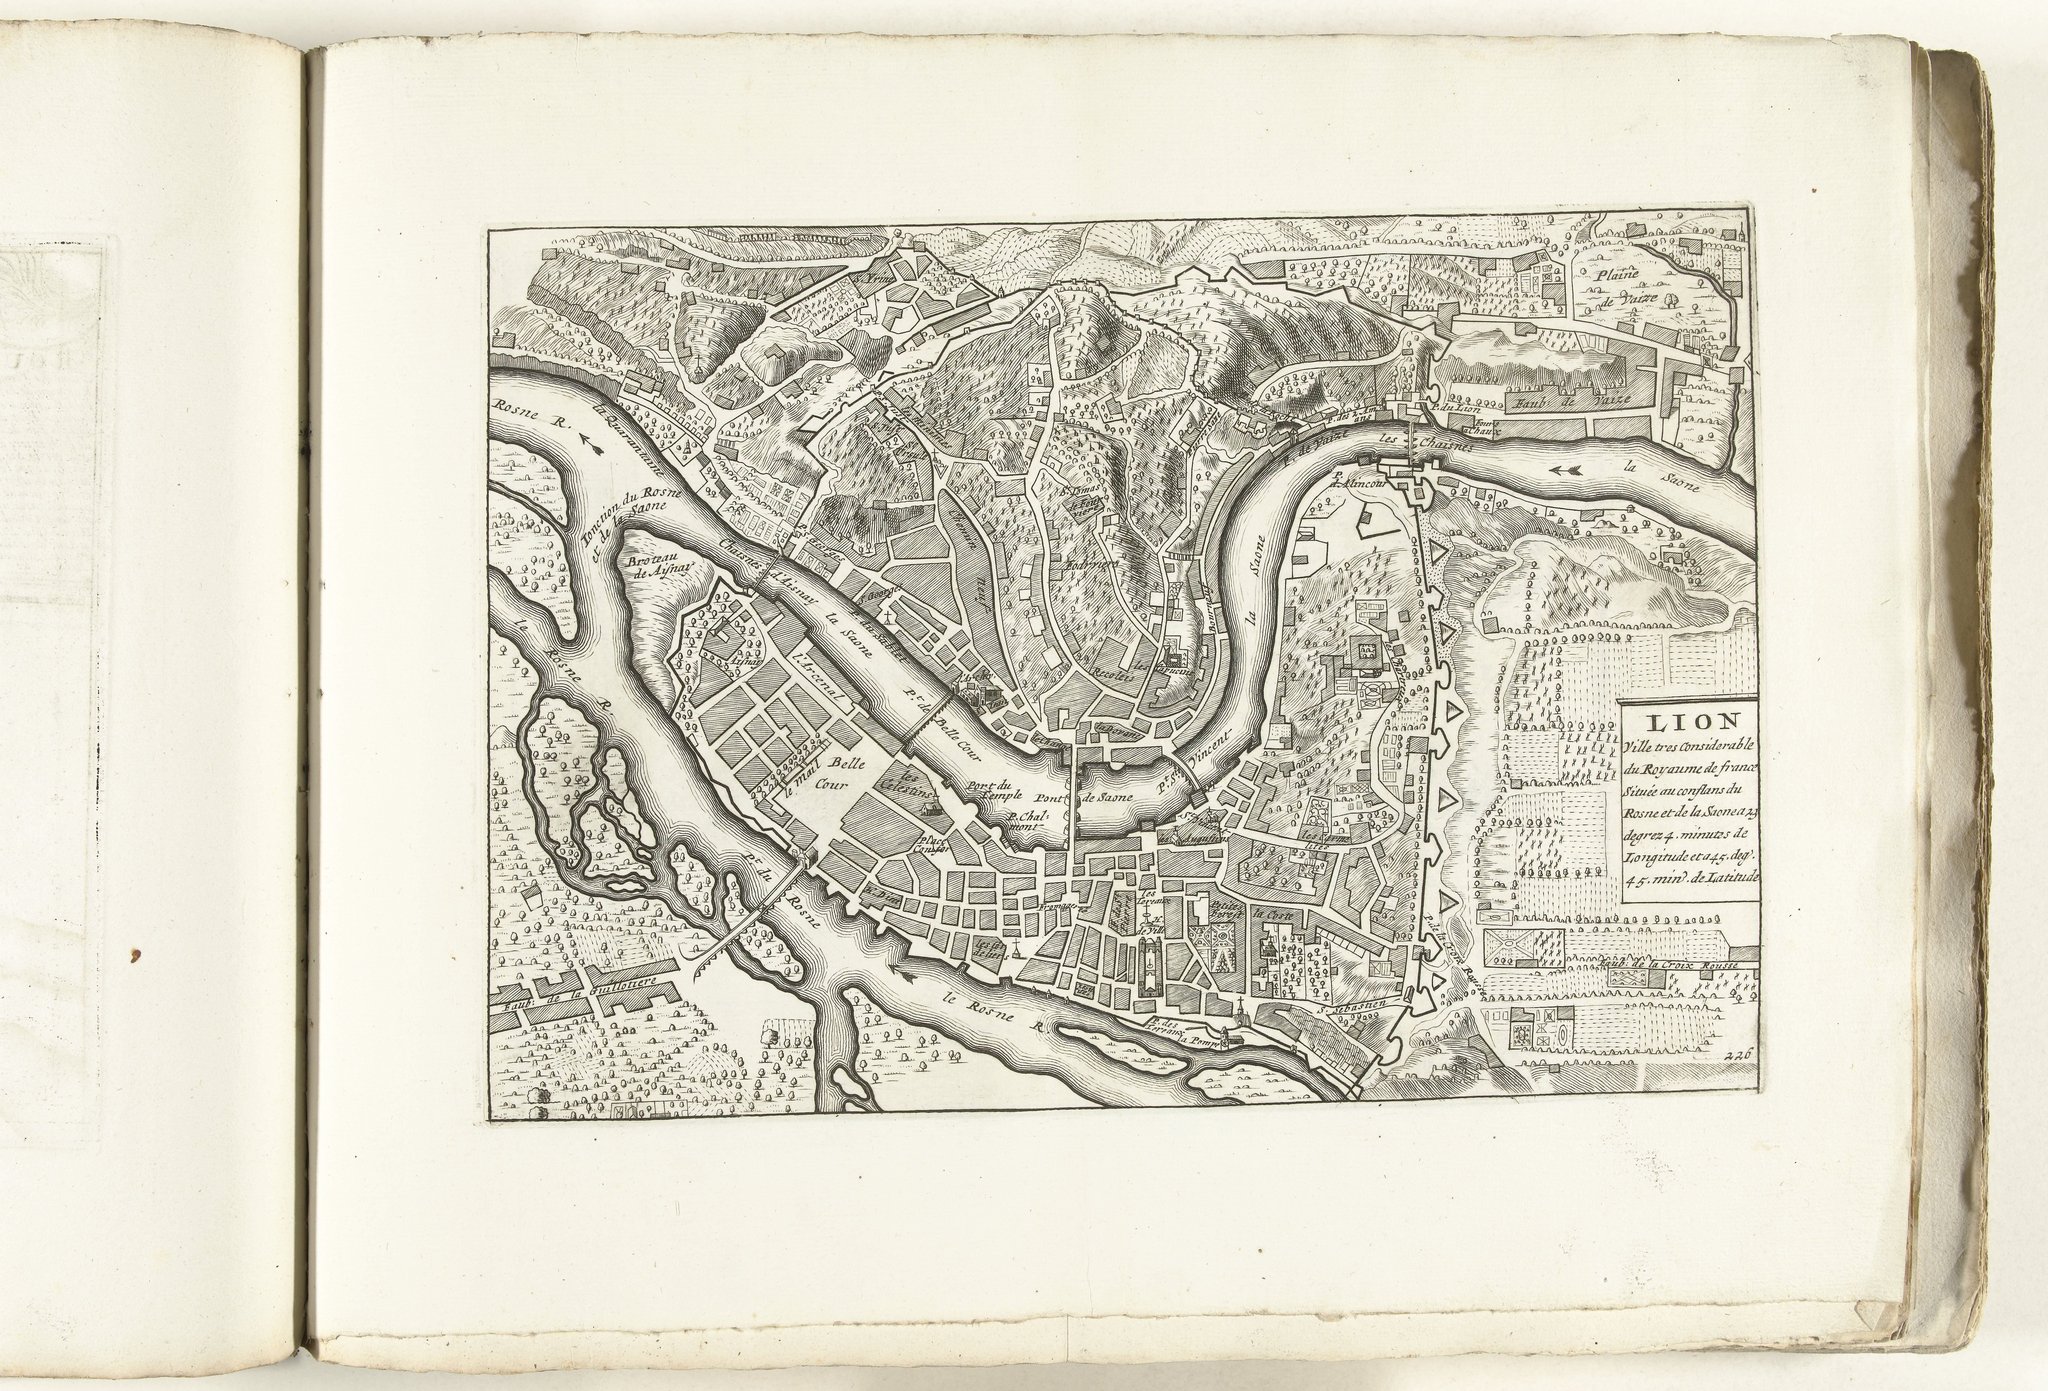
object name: print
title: Lion Ville tres Considerable du Royaume de france (...)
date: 1702-1703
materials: paper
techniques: engraving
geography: amsterdam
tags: maps of cities, lyon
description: Plattegrond van de Franse stad Lyon. Plaat nr. 226 in het prentwerk bestaande in totaal uit 276 genummerde platen van vermaarde sterke steden en vestingen in het kader van de Spaanse Successieoorlog. Voor het merendeel zijn deze platen gekopieerd naar de anonieme Franse platen: in Les forces de l'Europe en in: Le theatre de la guerre, dans les Pays-Bas, beide oorspronkelijk uitgegeven door Nicolas de Fer te Parijs (1693-1697) in het kader van de Negenjarige Oorlog. Titel en opschriften in de plaat in het Frans.